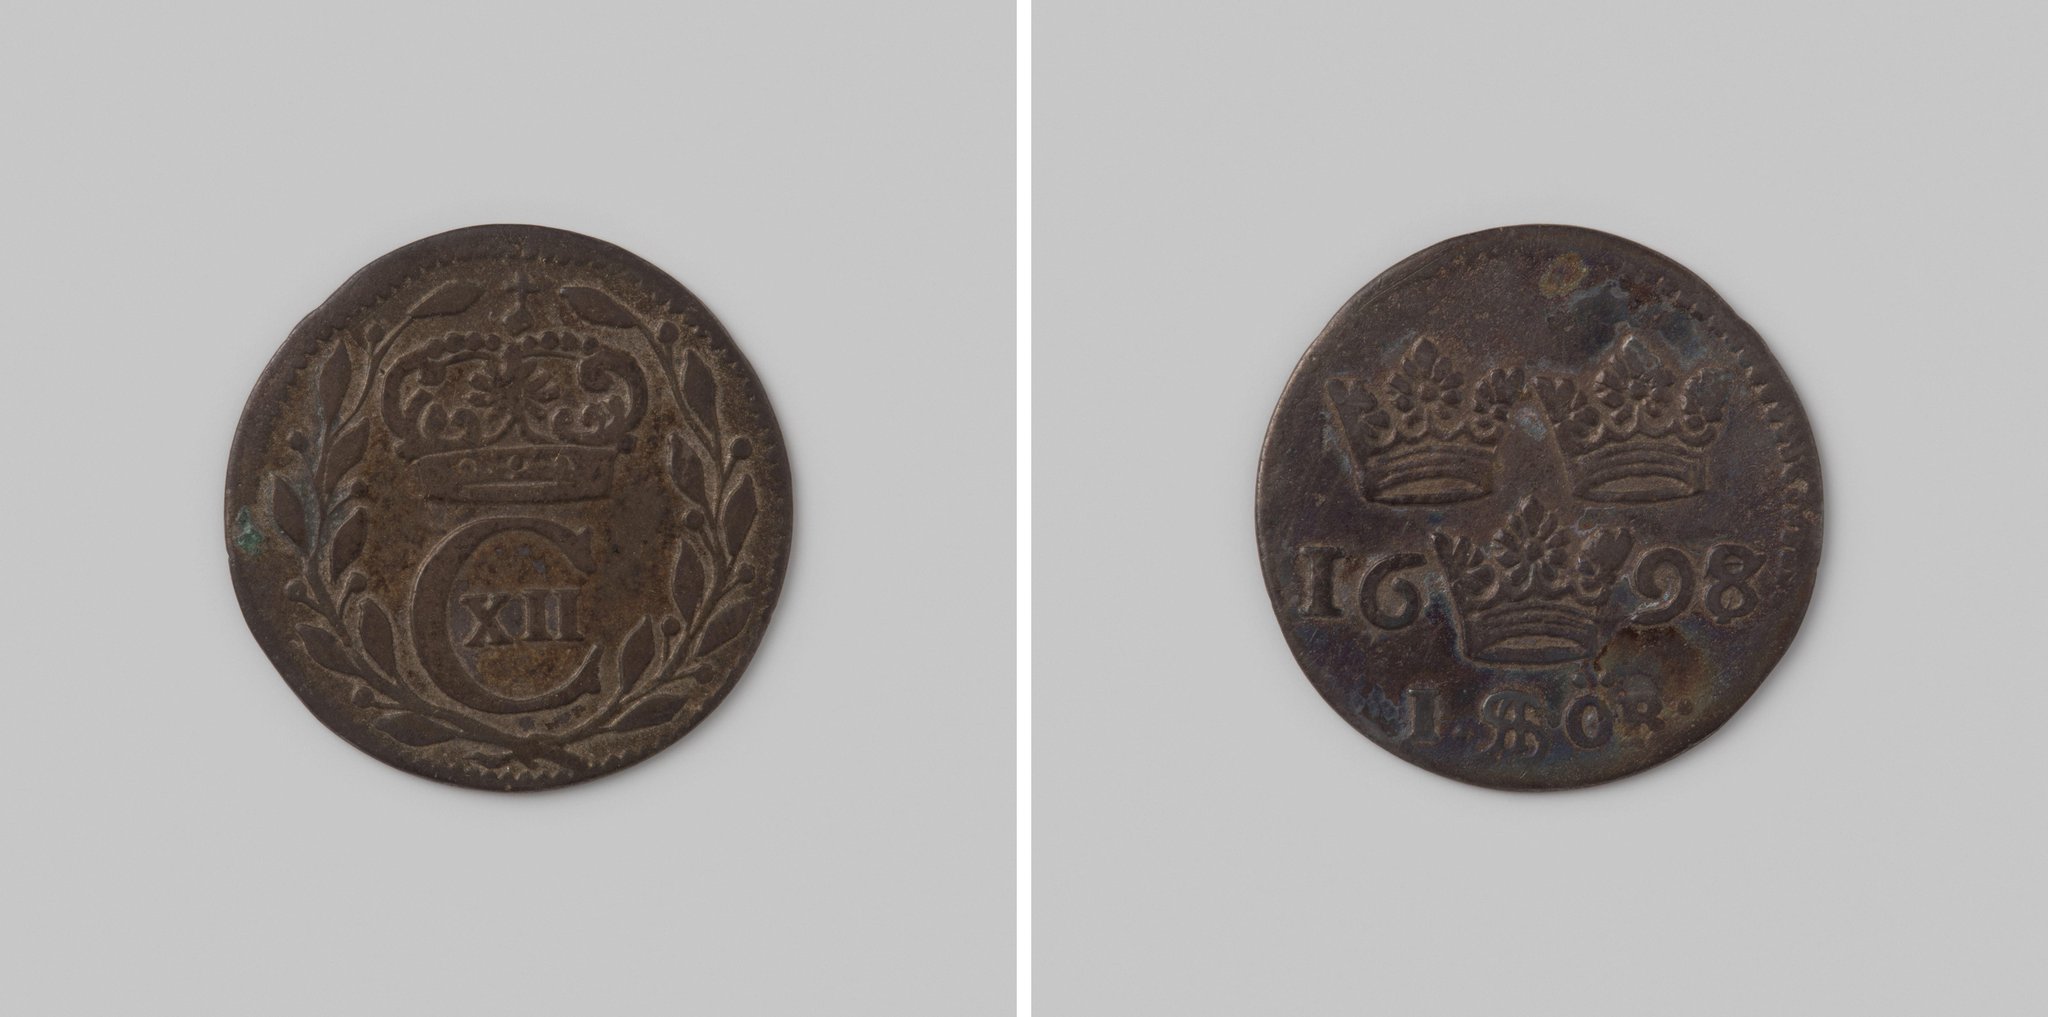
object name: coin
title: öre uit Zweden van Karel XII, 1698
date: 1698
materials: silver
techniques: striking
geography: slot rörstrand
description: Zilveren munt. Voorzijde: tussen twee samengebonden takken letters C,waarin XII. Daarboven kroon. Keerzijde: tussen jaartal drie kronen, waaronder waarde-aanduiding. Gladde rand.